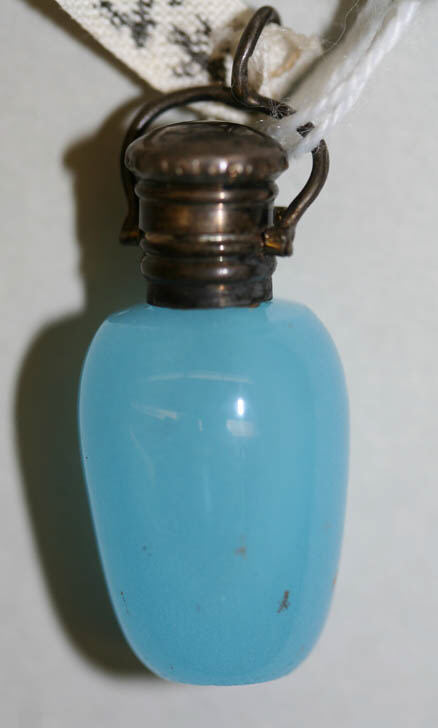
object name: pendant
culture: american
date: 1801-1833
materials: glass